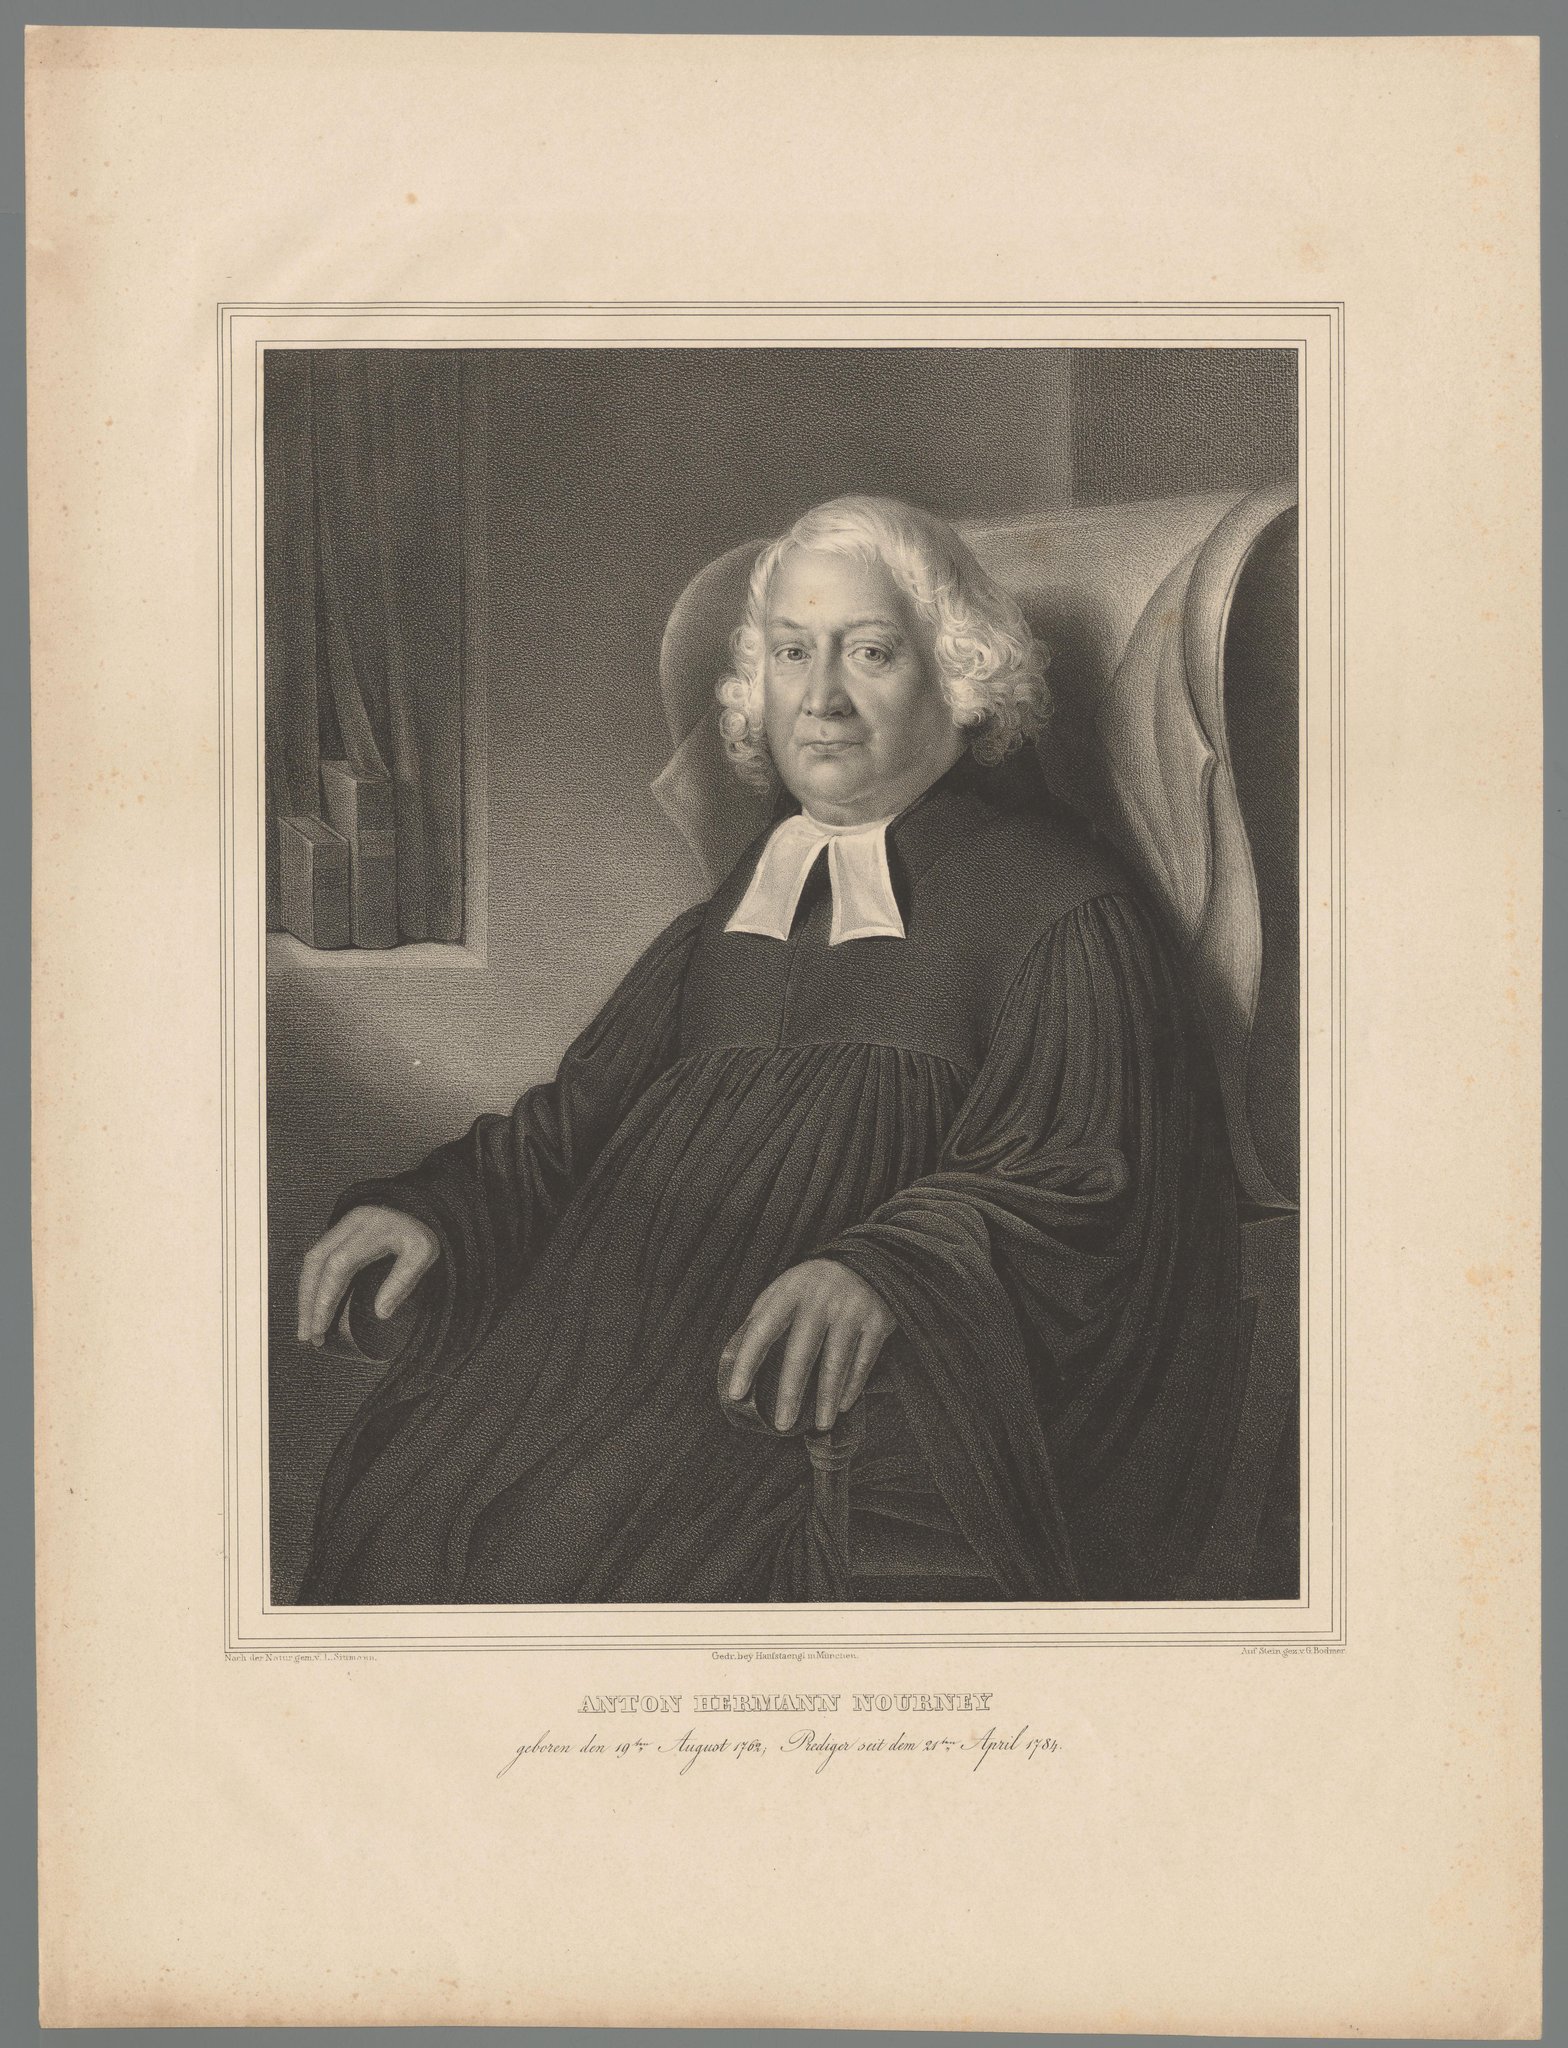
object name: print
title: Portret van Anton Hermann Nourney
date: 1814-1837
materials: paper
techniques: lithograph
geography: munich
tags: armchair, seat, adult man, historical persons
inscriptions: collector's mark: Lugt 2228